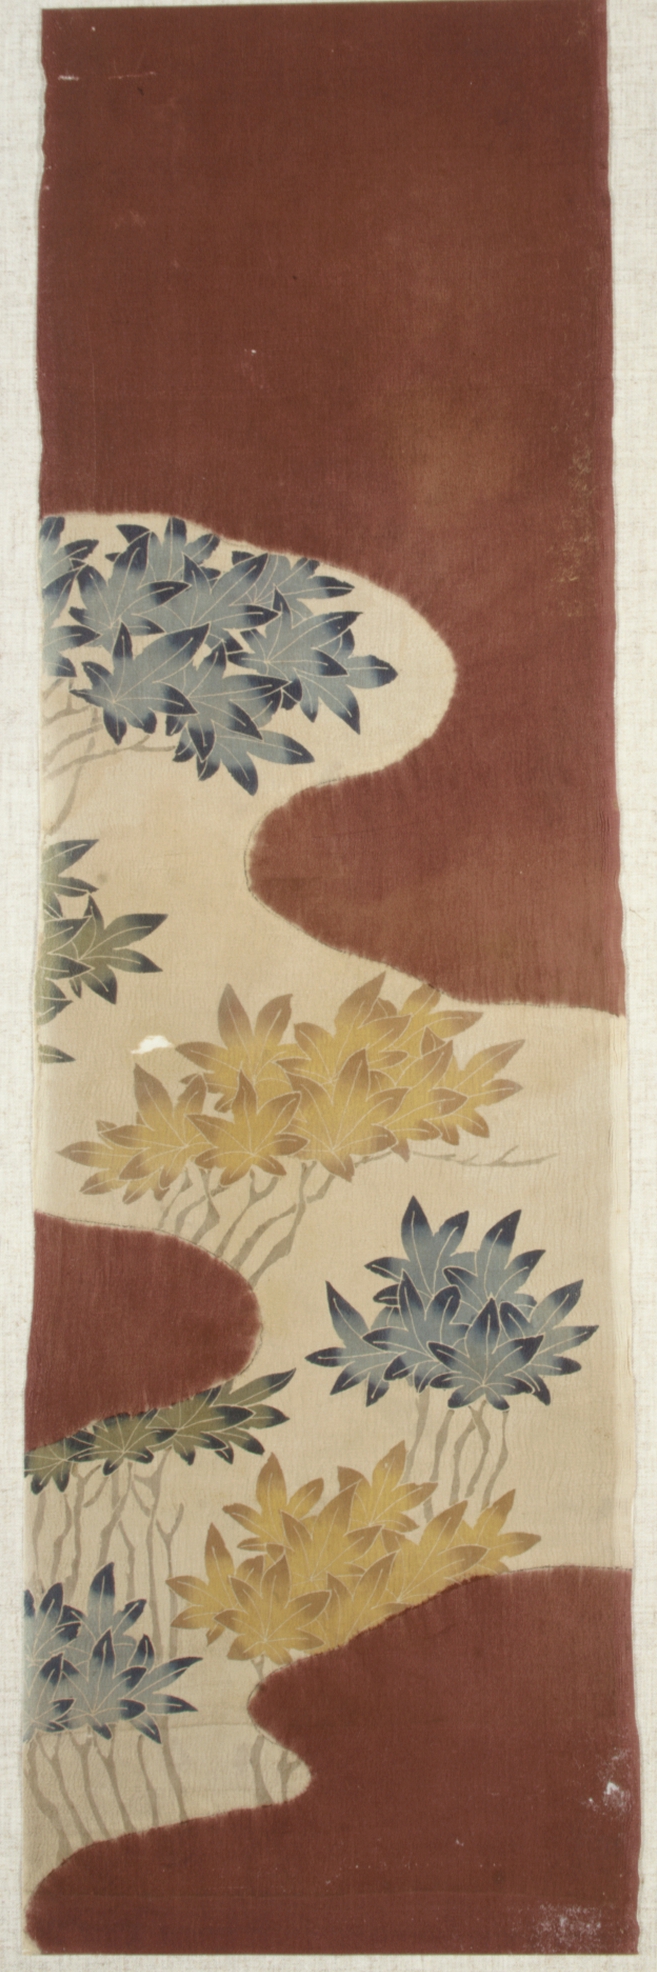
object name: piece from a kosode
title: Piece from a Robe (Kosode) with Pattern of Maple Leaves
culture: japanese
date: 1667-1800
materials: paste, silk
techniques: dyeing, painting, resist, stitching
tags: flowers